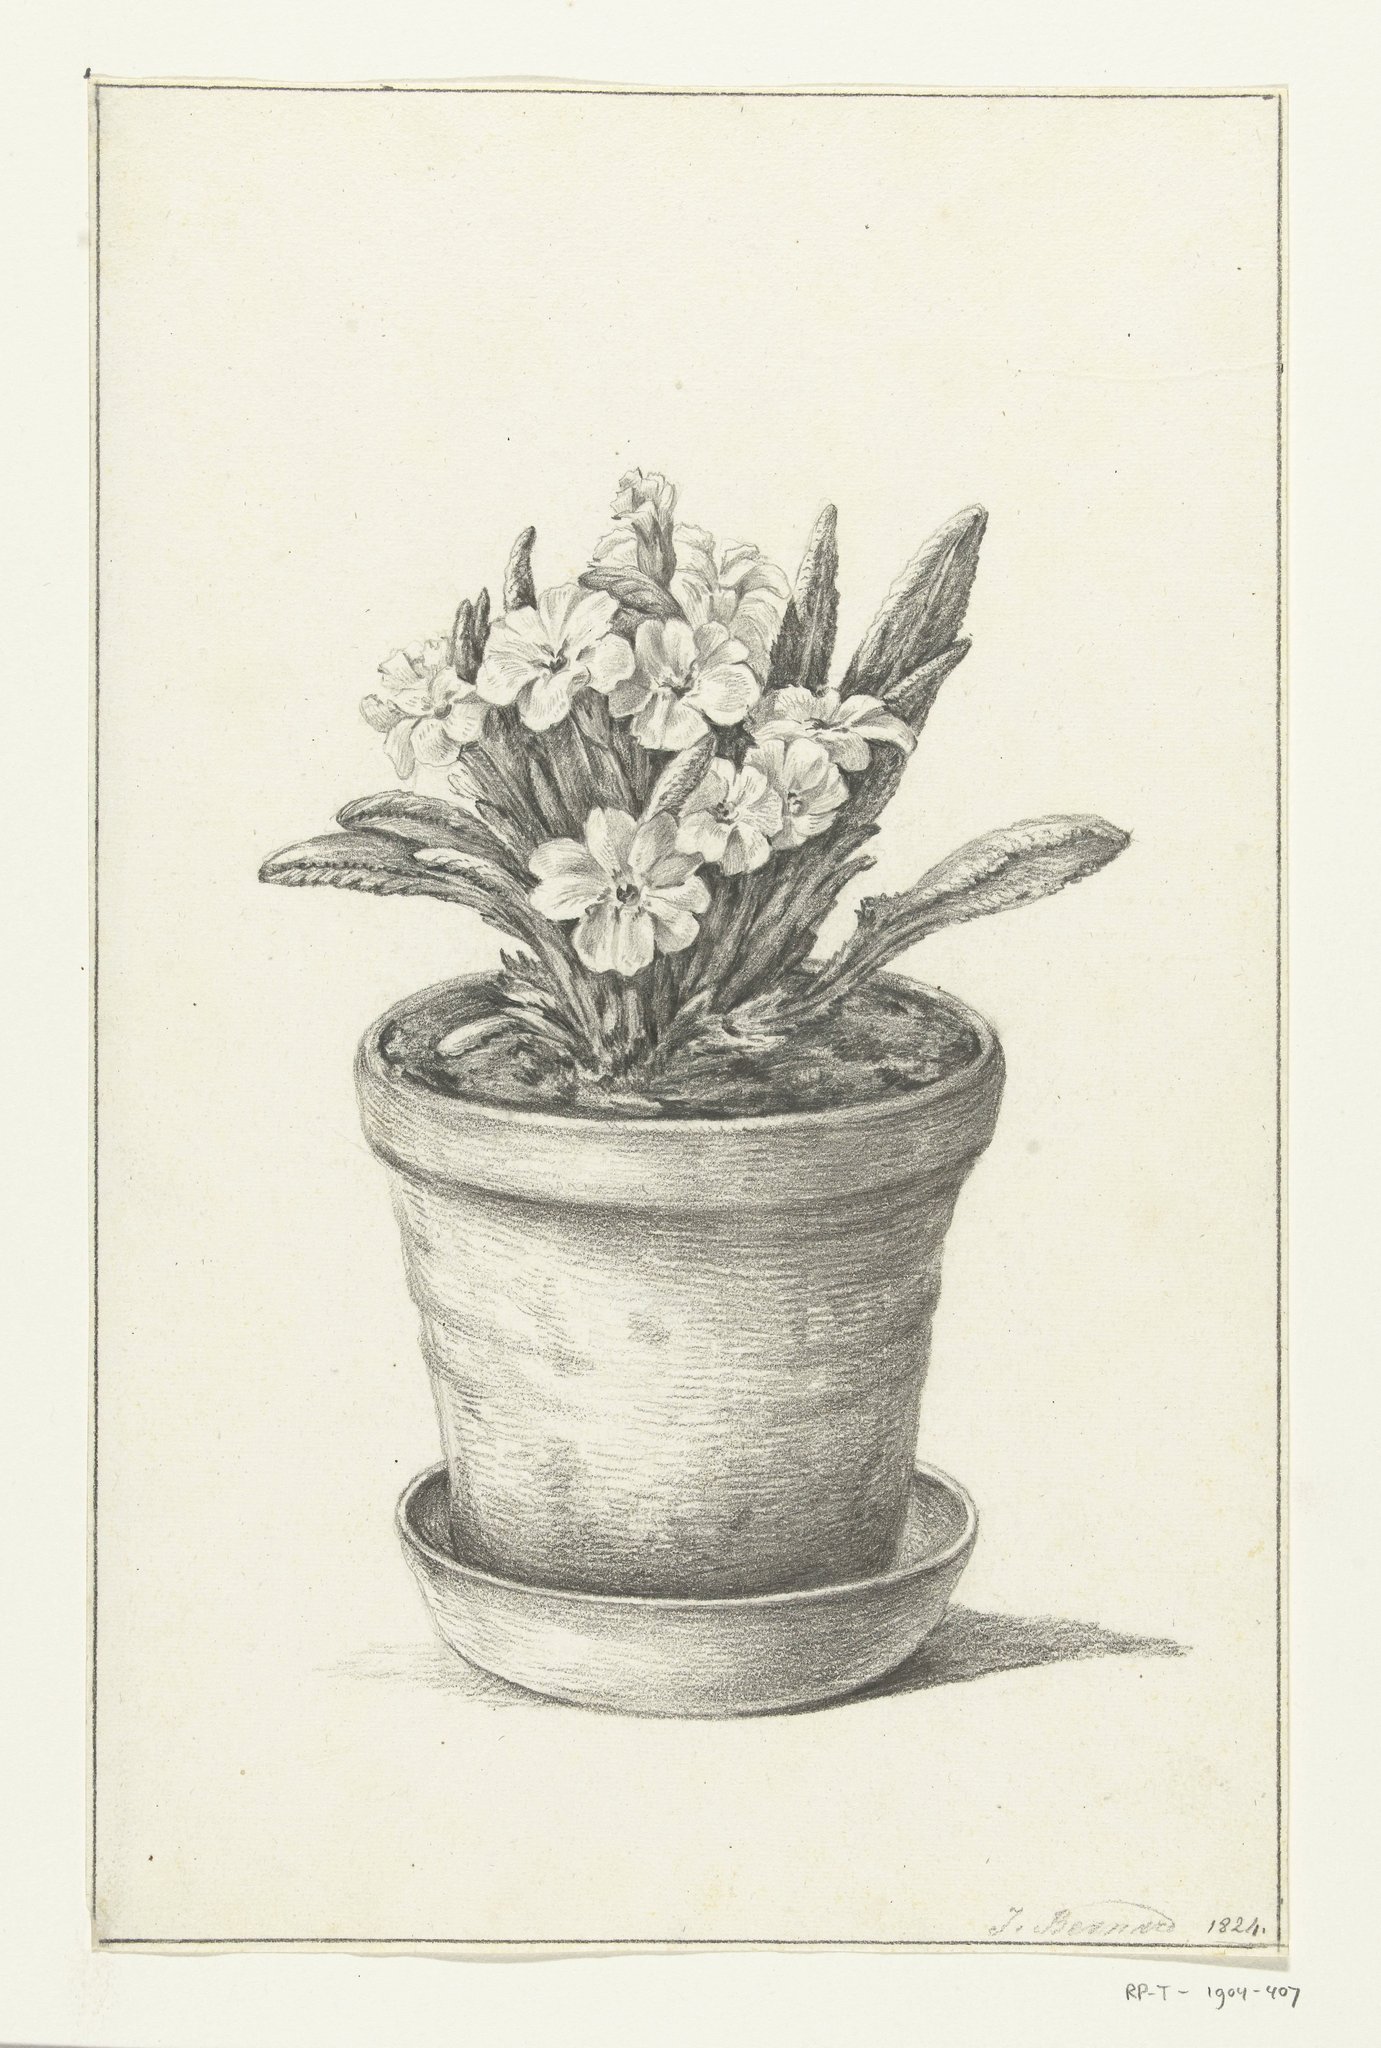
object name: drawing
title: Potplant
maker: jean bernard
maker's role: draughtsman, print maker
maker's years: 1765-1833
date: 1824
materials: chalk, paper, pencil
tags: flowers